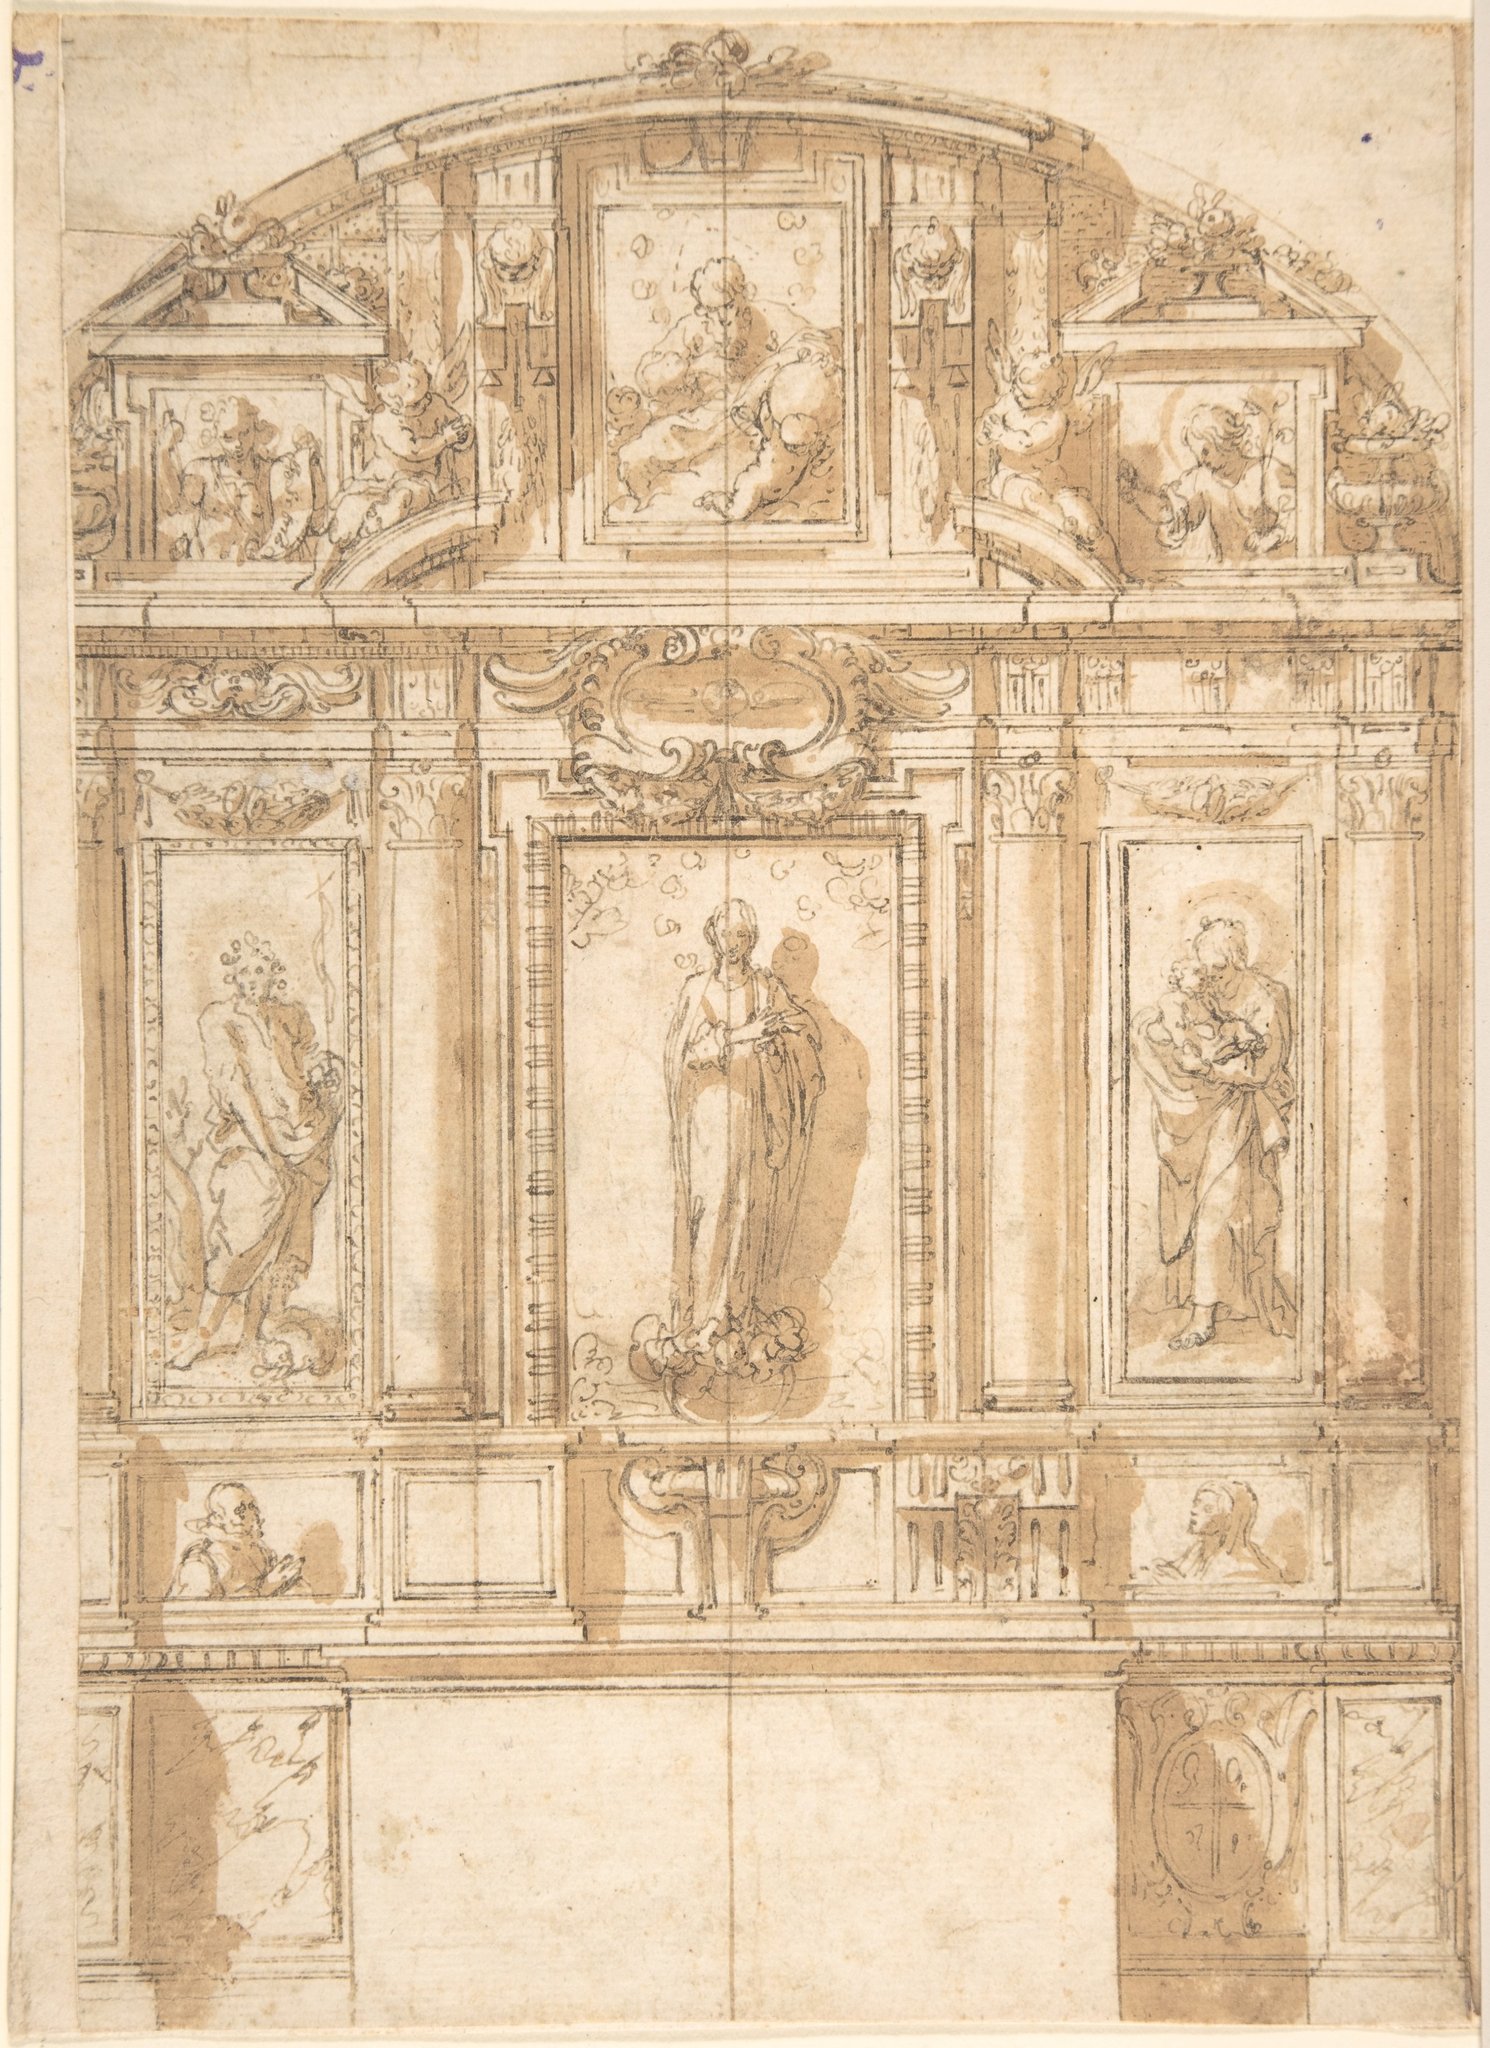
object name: drawing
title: Design for an Altar with the Virgin of the Immaculate Conception in the Center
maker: anonymous, spanish, 17th century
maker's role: artist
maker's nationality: spanish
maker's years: 1600-1700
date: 1601-1700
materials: chalk, ink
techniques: brush, pen, wash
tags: altars,angels,virgin mary